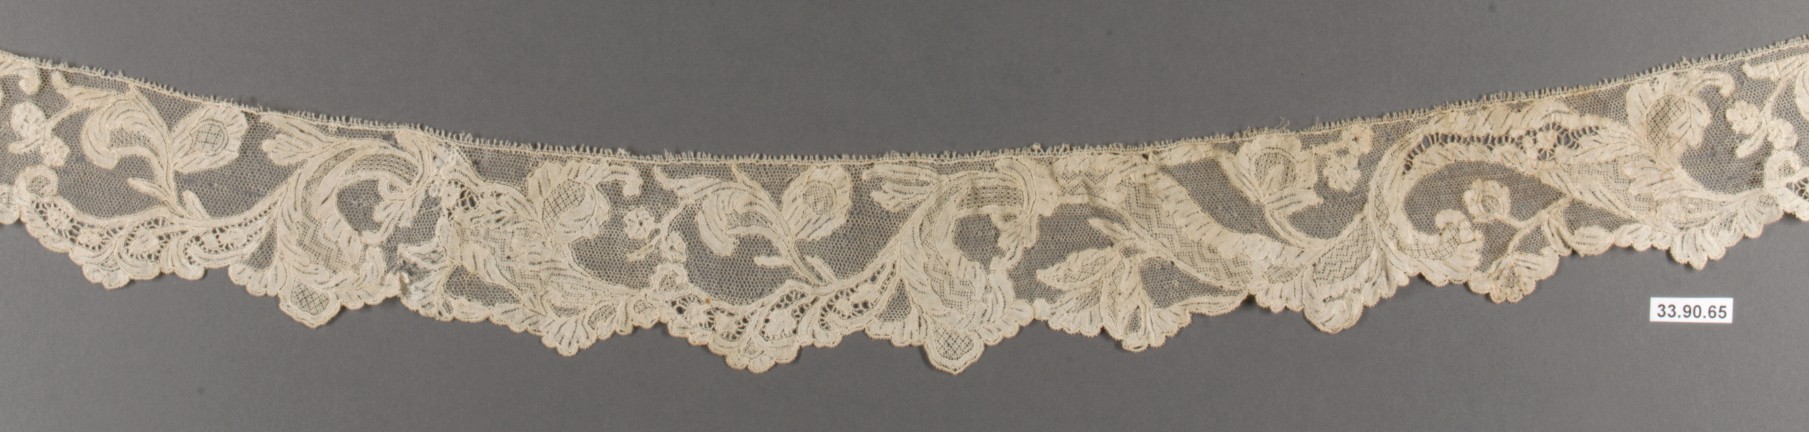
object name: edging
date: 1701-1800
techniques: lace